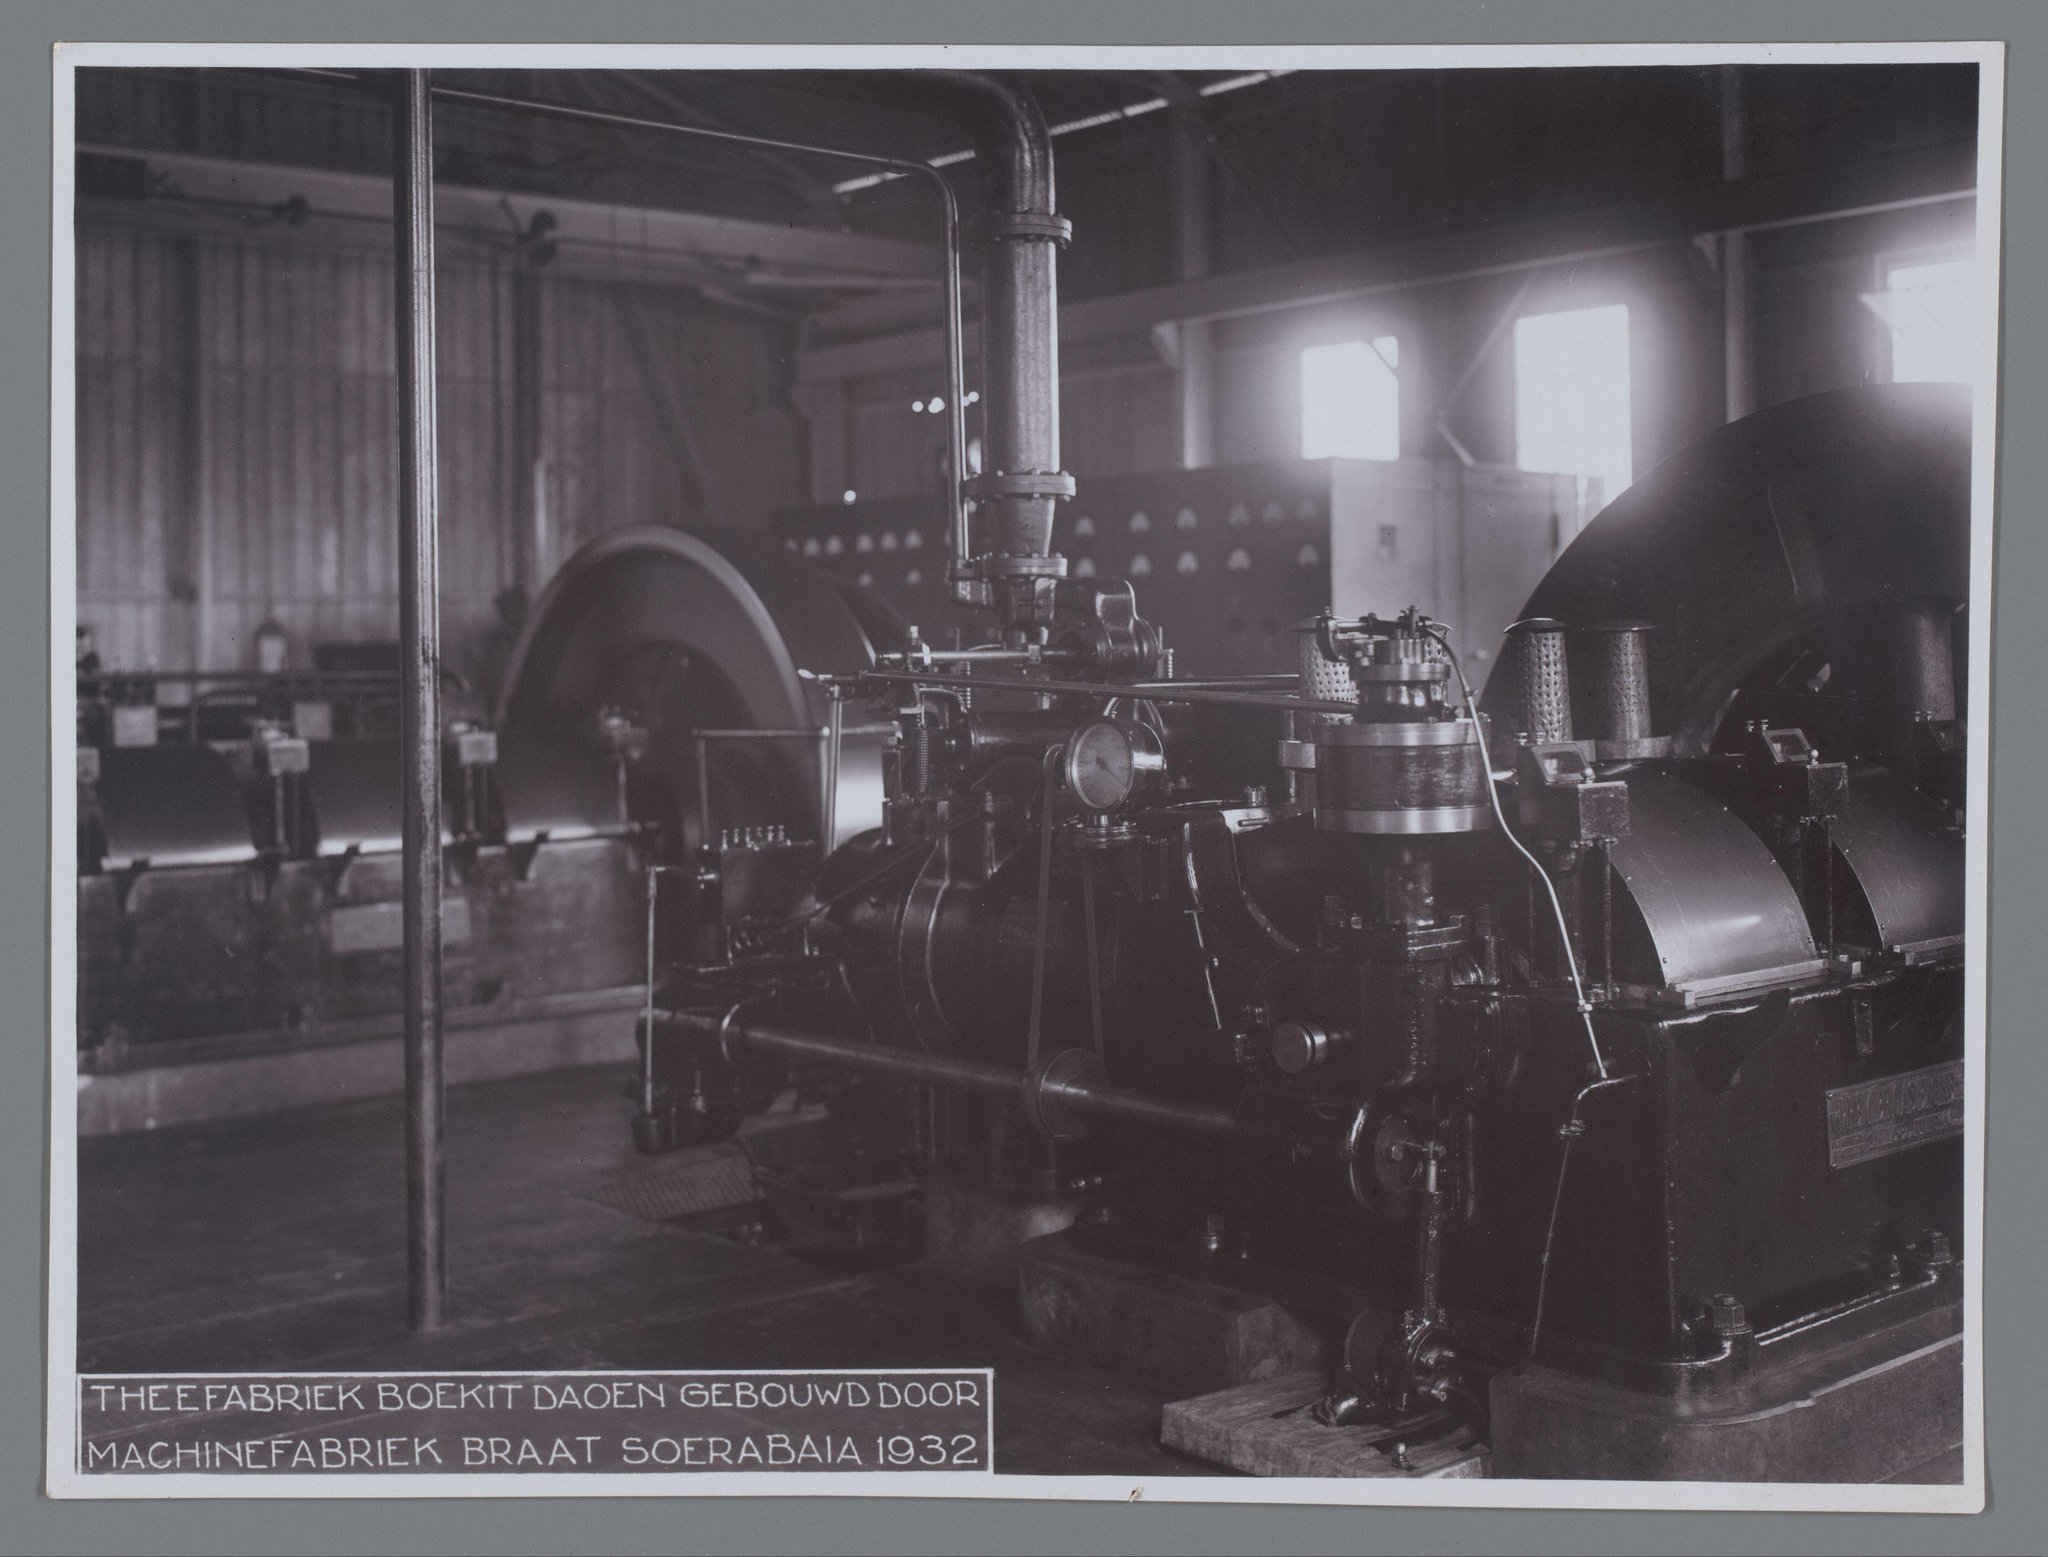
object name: photograph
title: Gasmachines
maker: Anonymous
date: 1932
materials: photographic support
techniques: gelatin silver print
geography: sumatra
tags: colonial system, factory-interior, machine shop, machines; parts of machines; tools and appliances, (non-fruit) products of plants or trees (with name), tea (leaves), java, sumatra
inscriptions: date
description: Gasmachines in de theefabriek Boekit Daoen op Sumatra, gebouwd door Machinefabriek Braat in 1931-1932. Onderdeel van de multomap met foto's van machines van de N.V. Machinefabriek Braat te Soerabaja en Soekaboemi bestemd voor de Nederlandse theeindustrie op Java en Sumatra, uit de periode 1931-1937.